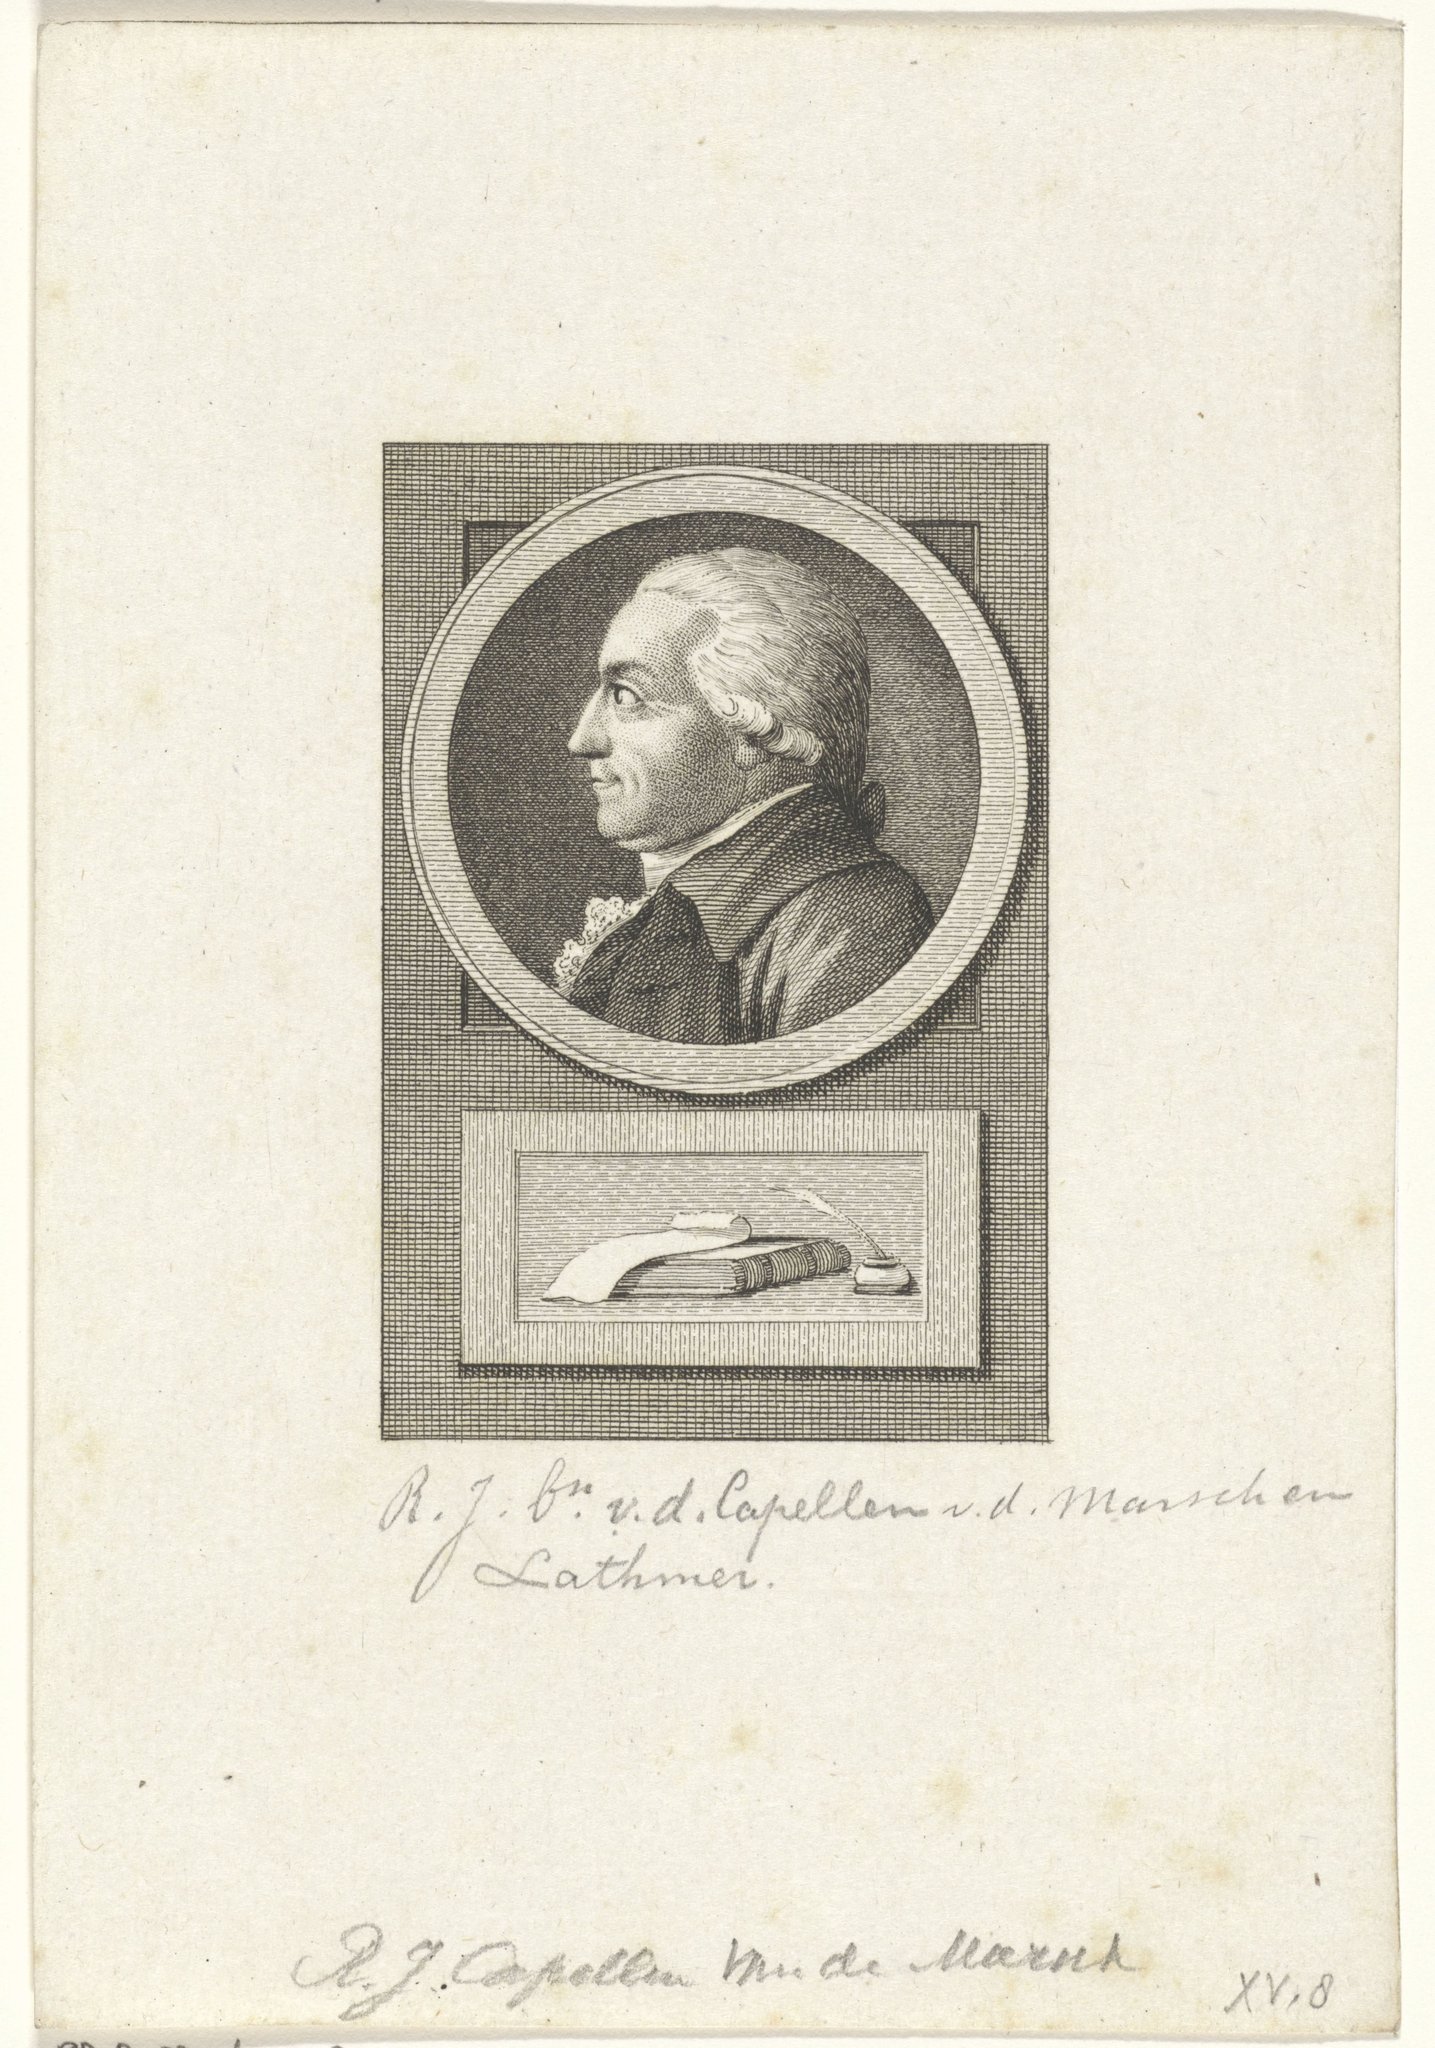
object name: print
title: Portret van Robert Jasper van der Capellen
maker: reinier vinkeles (i)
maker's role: draughtsman, print maker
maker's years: 1741-1816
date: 1783-1795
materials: paper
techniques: engraving, etching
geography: amsterdam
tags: deventer, quill, ink-well, paper (writing material)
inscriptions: collector's mark: Lugt 2228, inscription: ‘R.J.br.v.d.Capellen v.d.Marsch en Lathmer/ XV.8’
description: Latere staat prent gebruikt in: Fokke, Jan. Geschiedenissen der Vereenigde Nederlanden voor de vaderlandsche jeugd Ie-XXVste deel. Amsterdam: Johannes Allart, 1783-1795. Deel XV.